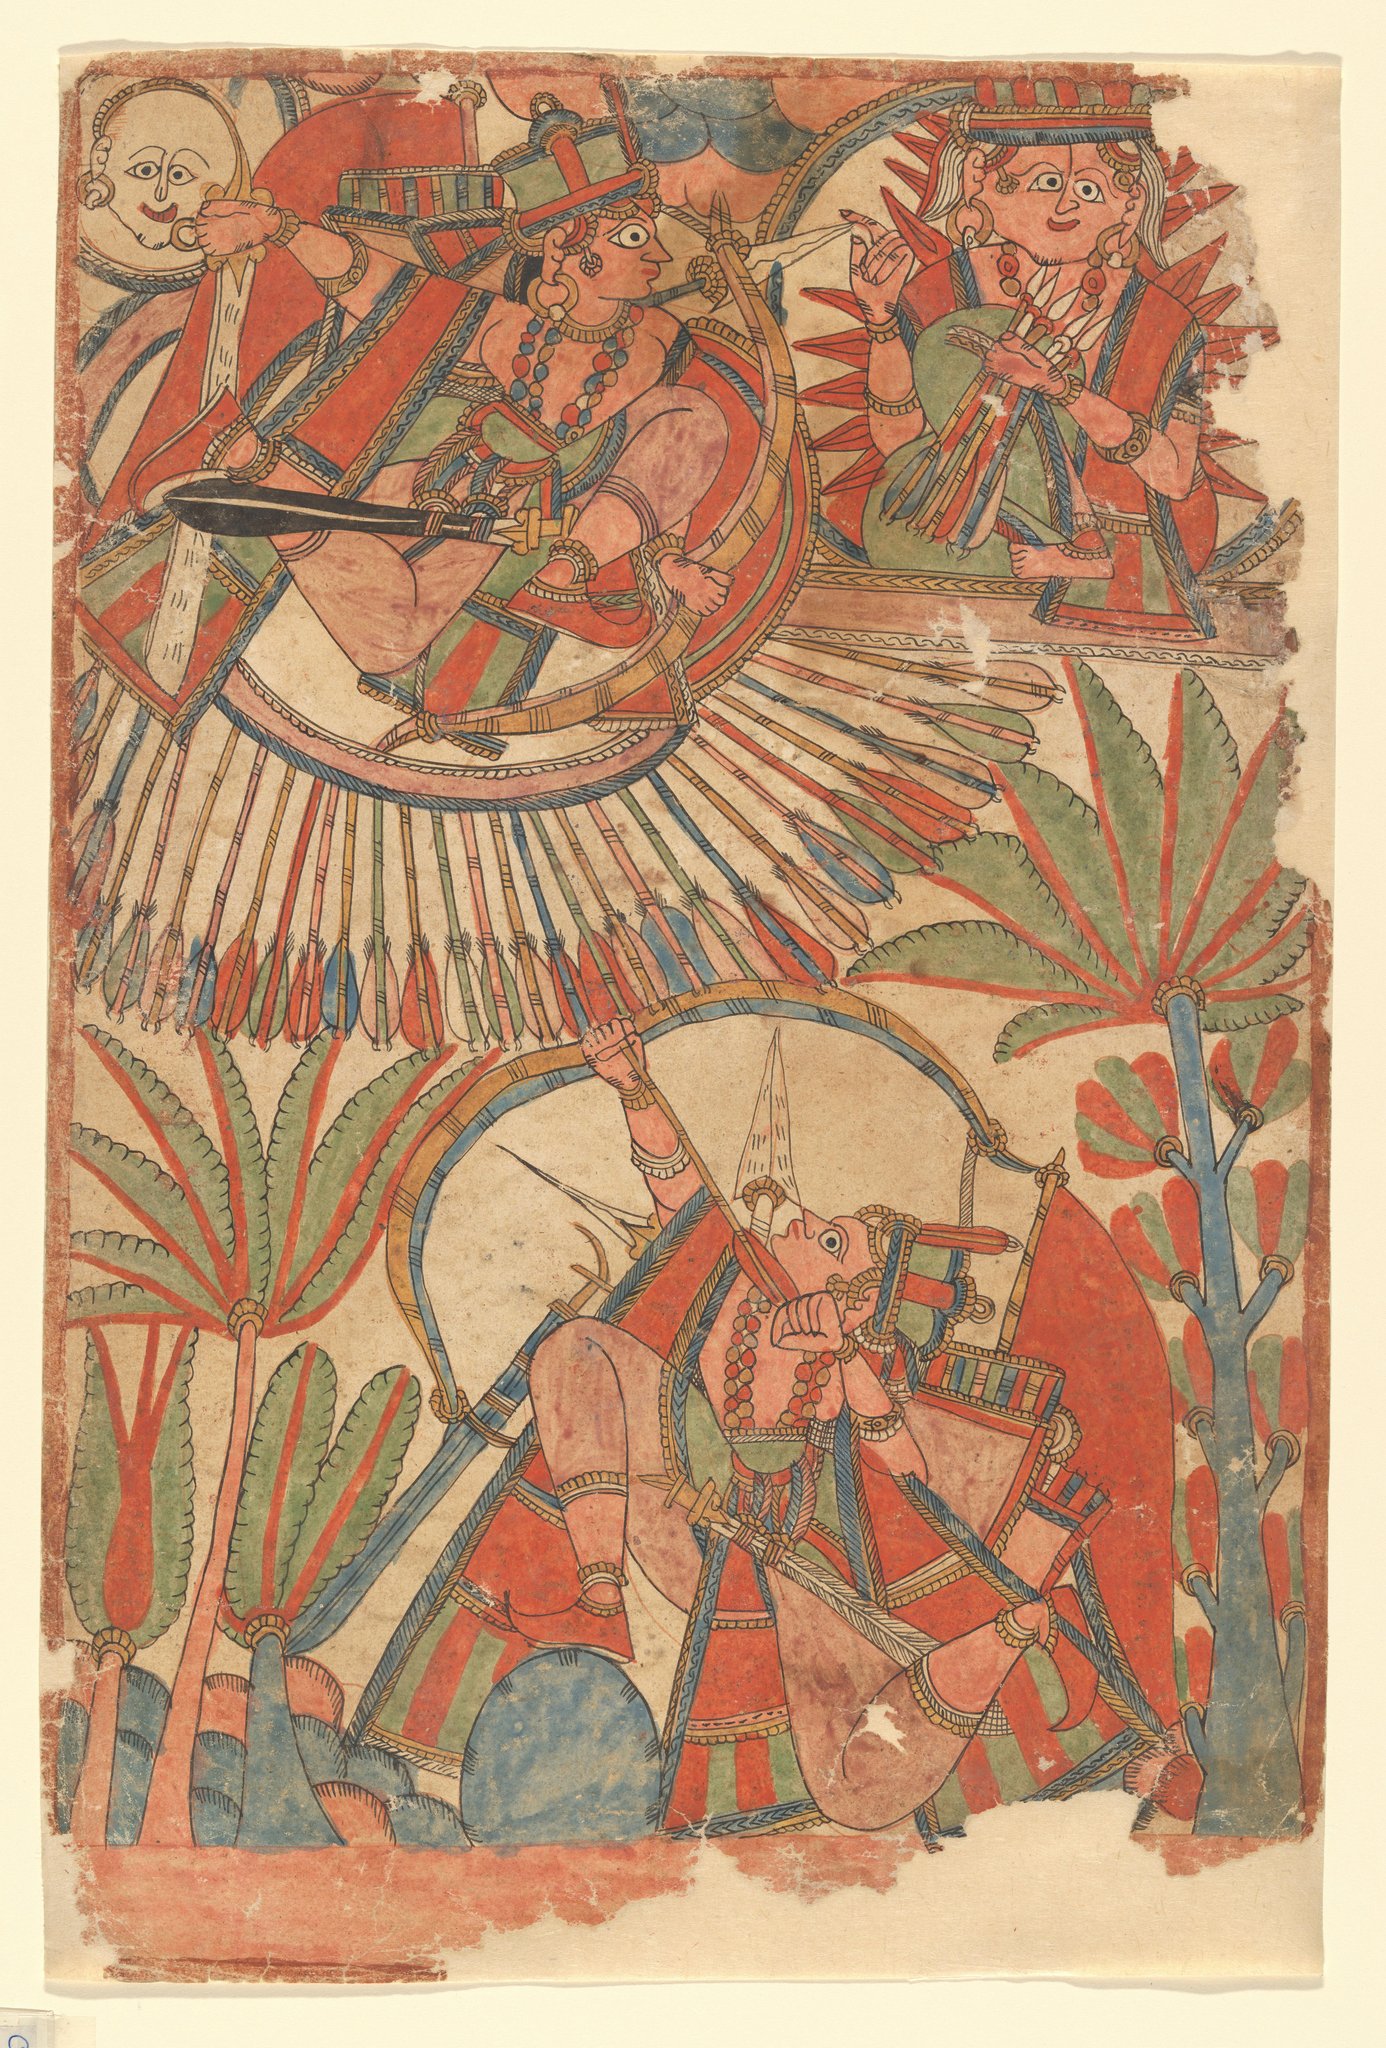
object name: indian miniature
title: Vrishaketu shoots Babhruvahana in the sky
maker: Anonymous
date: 1800-1899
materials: paper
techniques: brush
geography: andhra pradesh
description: Babhruvahana is depicted above, surrounded by the magical crescent-shaped arrow weapon and flanked by Sun and Moon. The five arrows in Sun's hand will be subsequently given to him. The personage at the bottom of the paintings is probably Vrishaketu. Alternatively, it might be Pradyumna (son of Balarama). The painting might illustrate the story of Babhruvahana as given by the Sripandavapratapa by Sridhara (c. 1658-1729). A better-known variant of the story is given by the Asvamedha Parvan of the Mahabharata. Paintings as this one were used by itinerant bards (chitrakathis) to accompany their recitations.